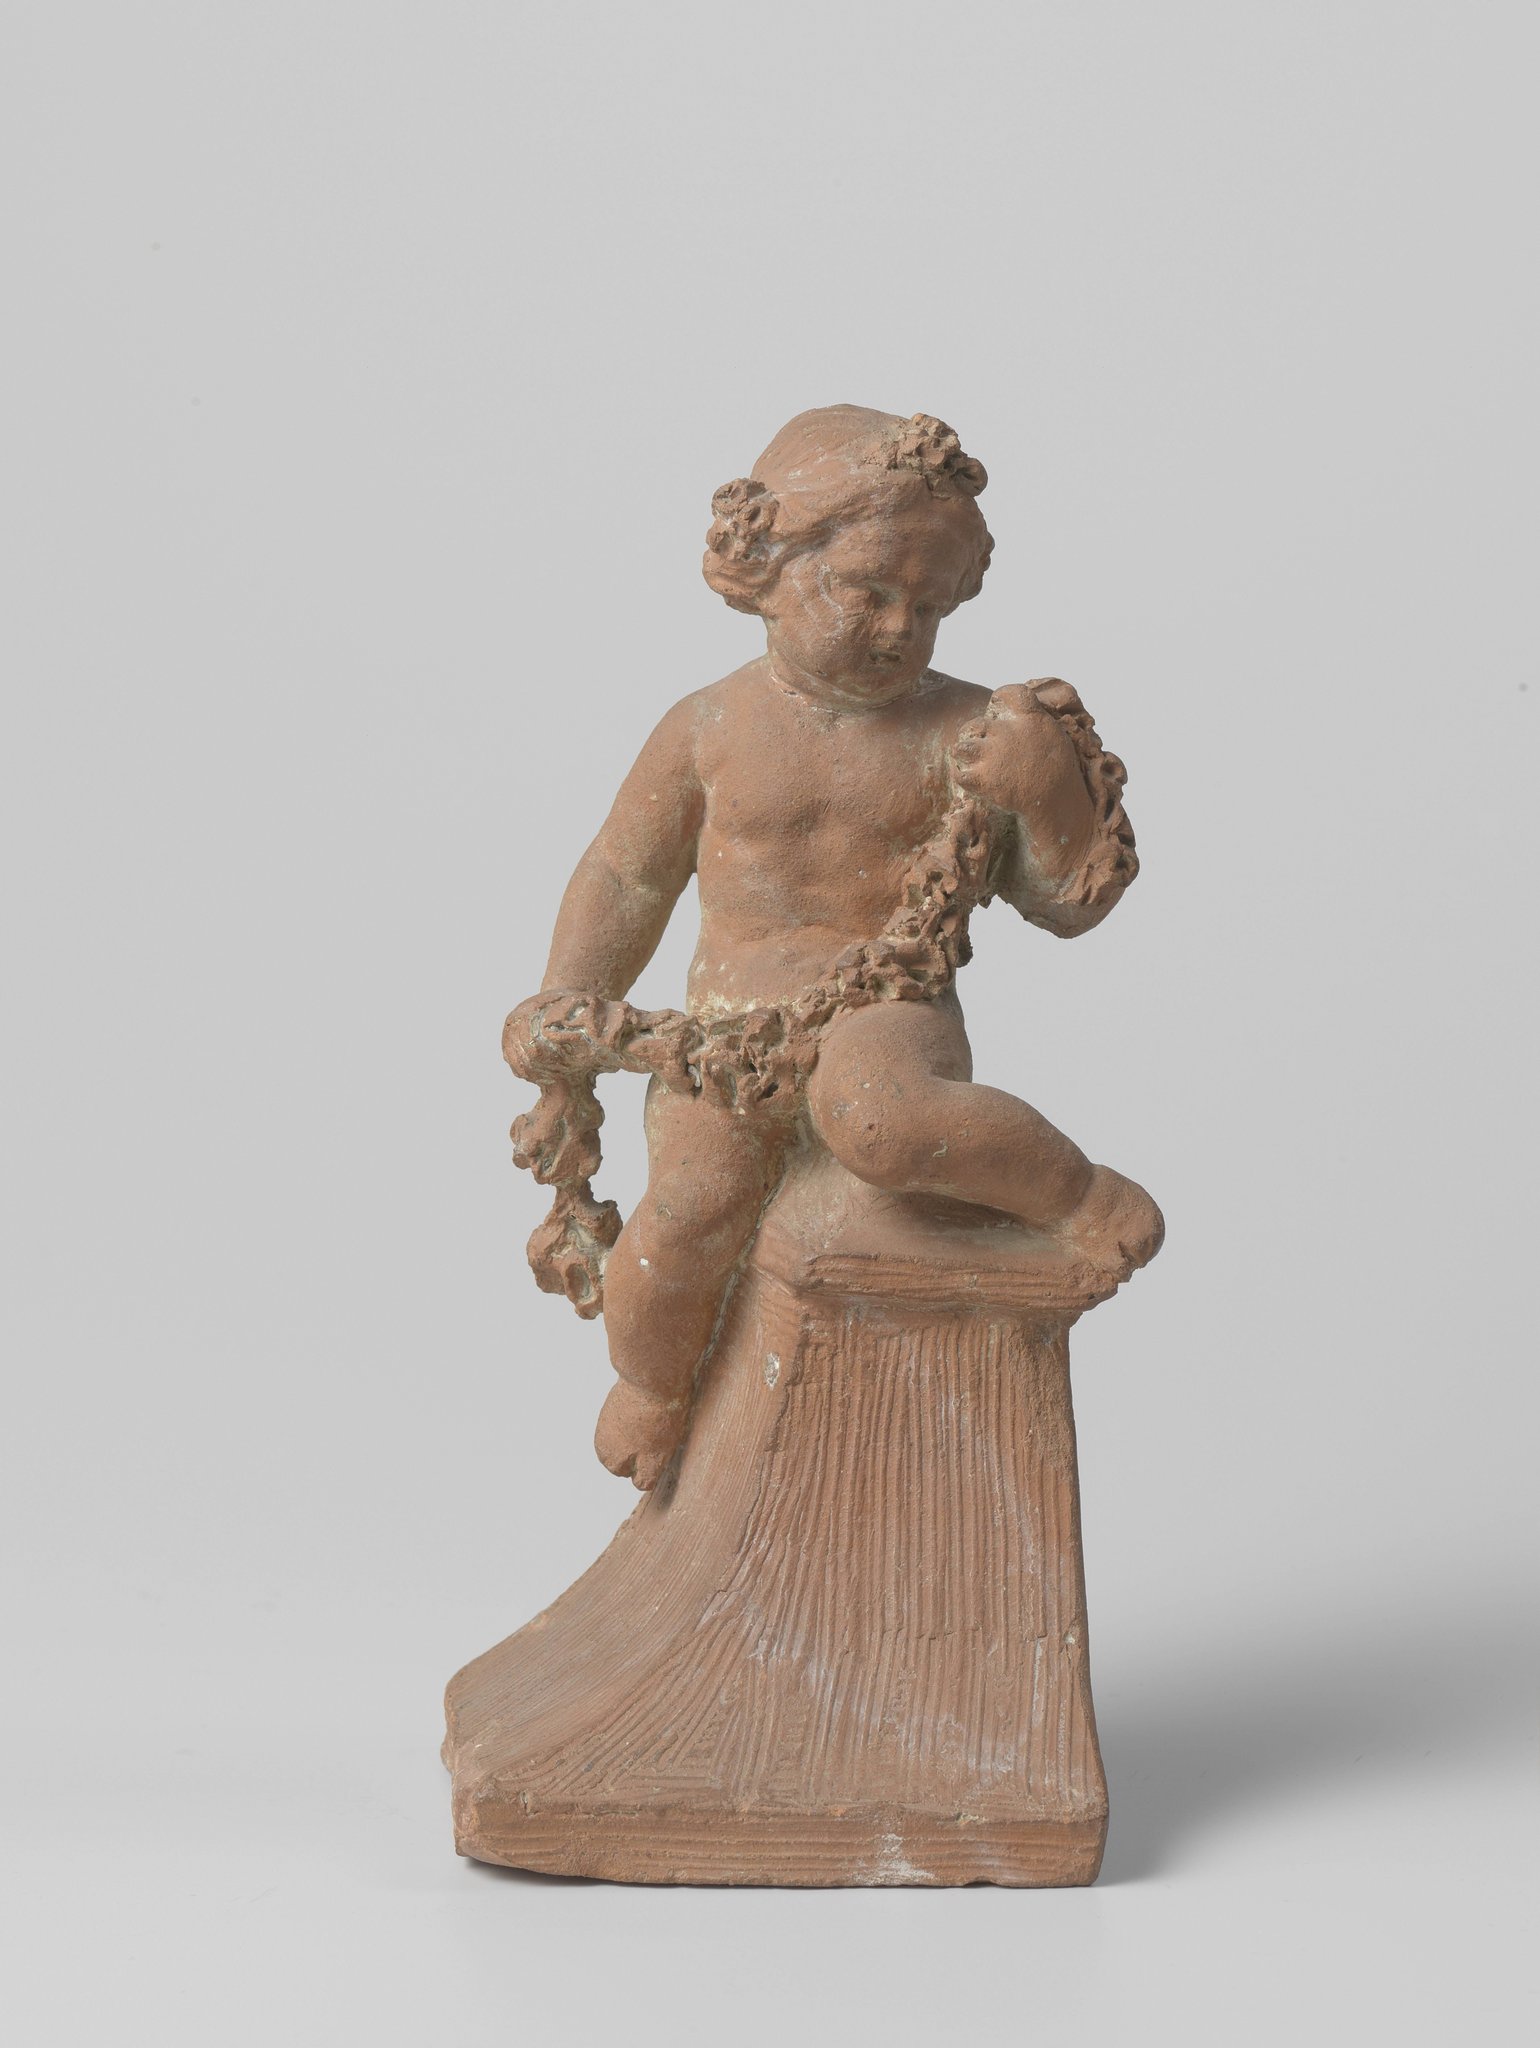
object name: sculpture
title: Jaargetijde, voorgesteld door kind met attribuut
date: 1725-1740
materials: terracotta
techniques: modeling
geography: northern netherlands